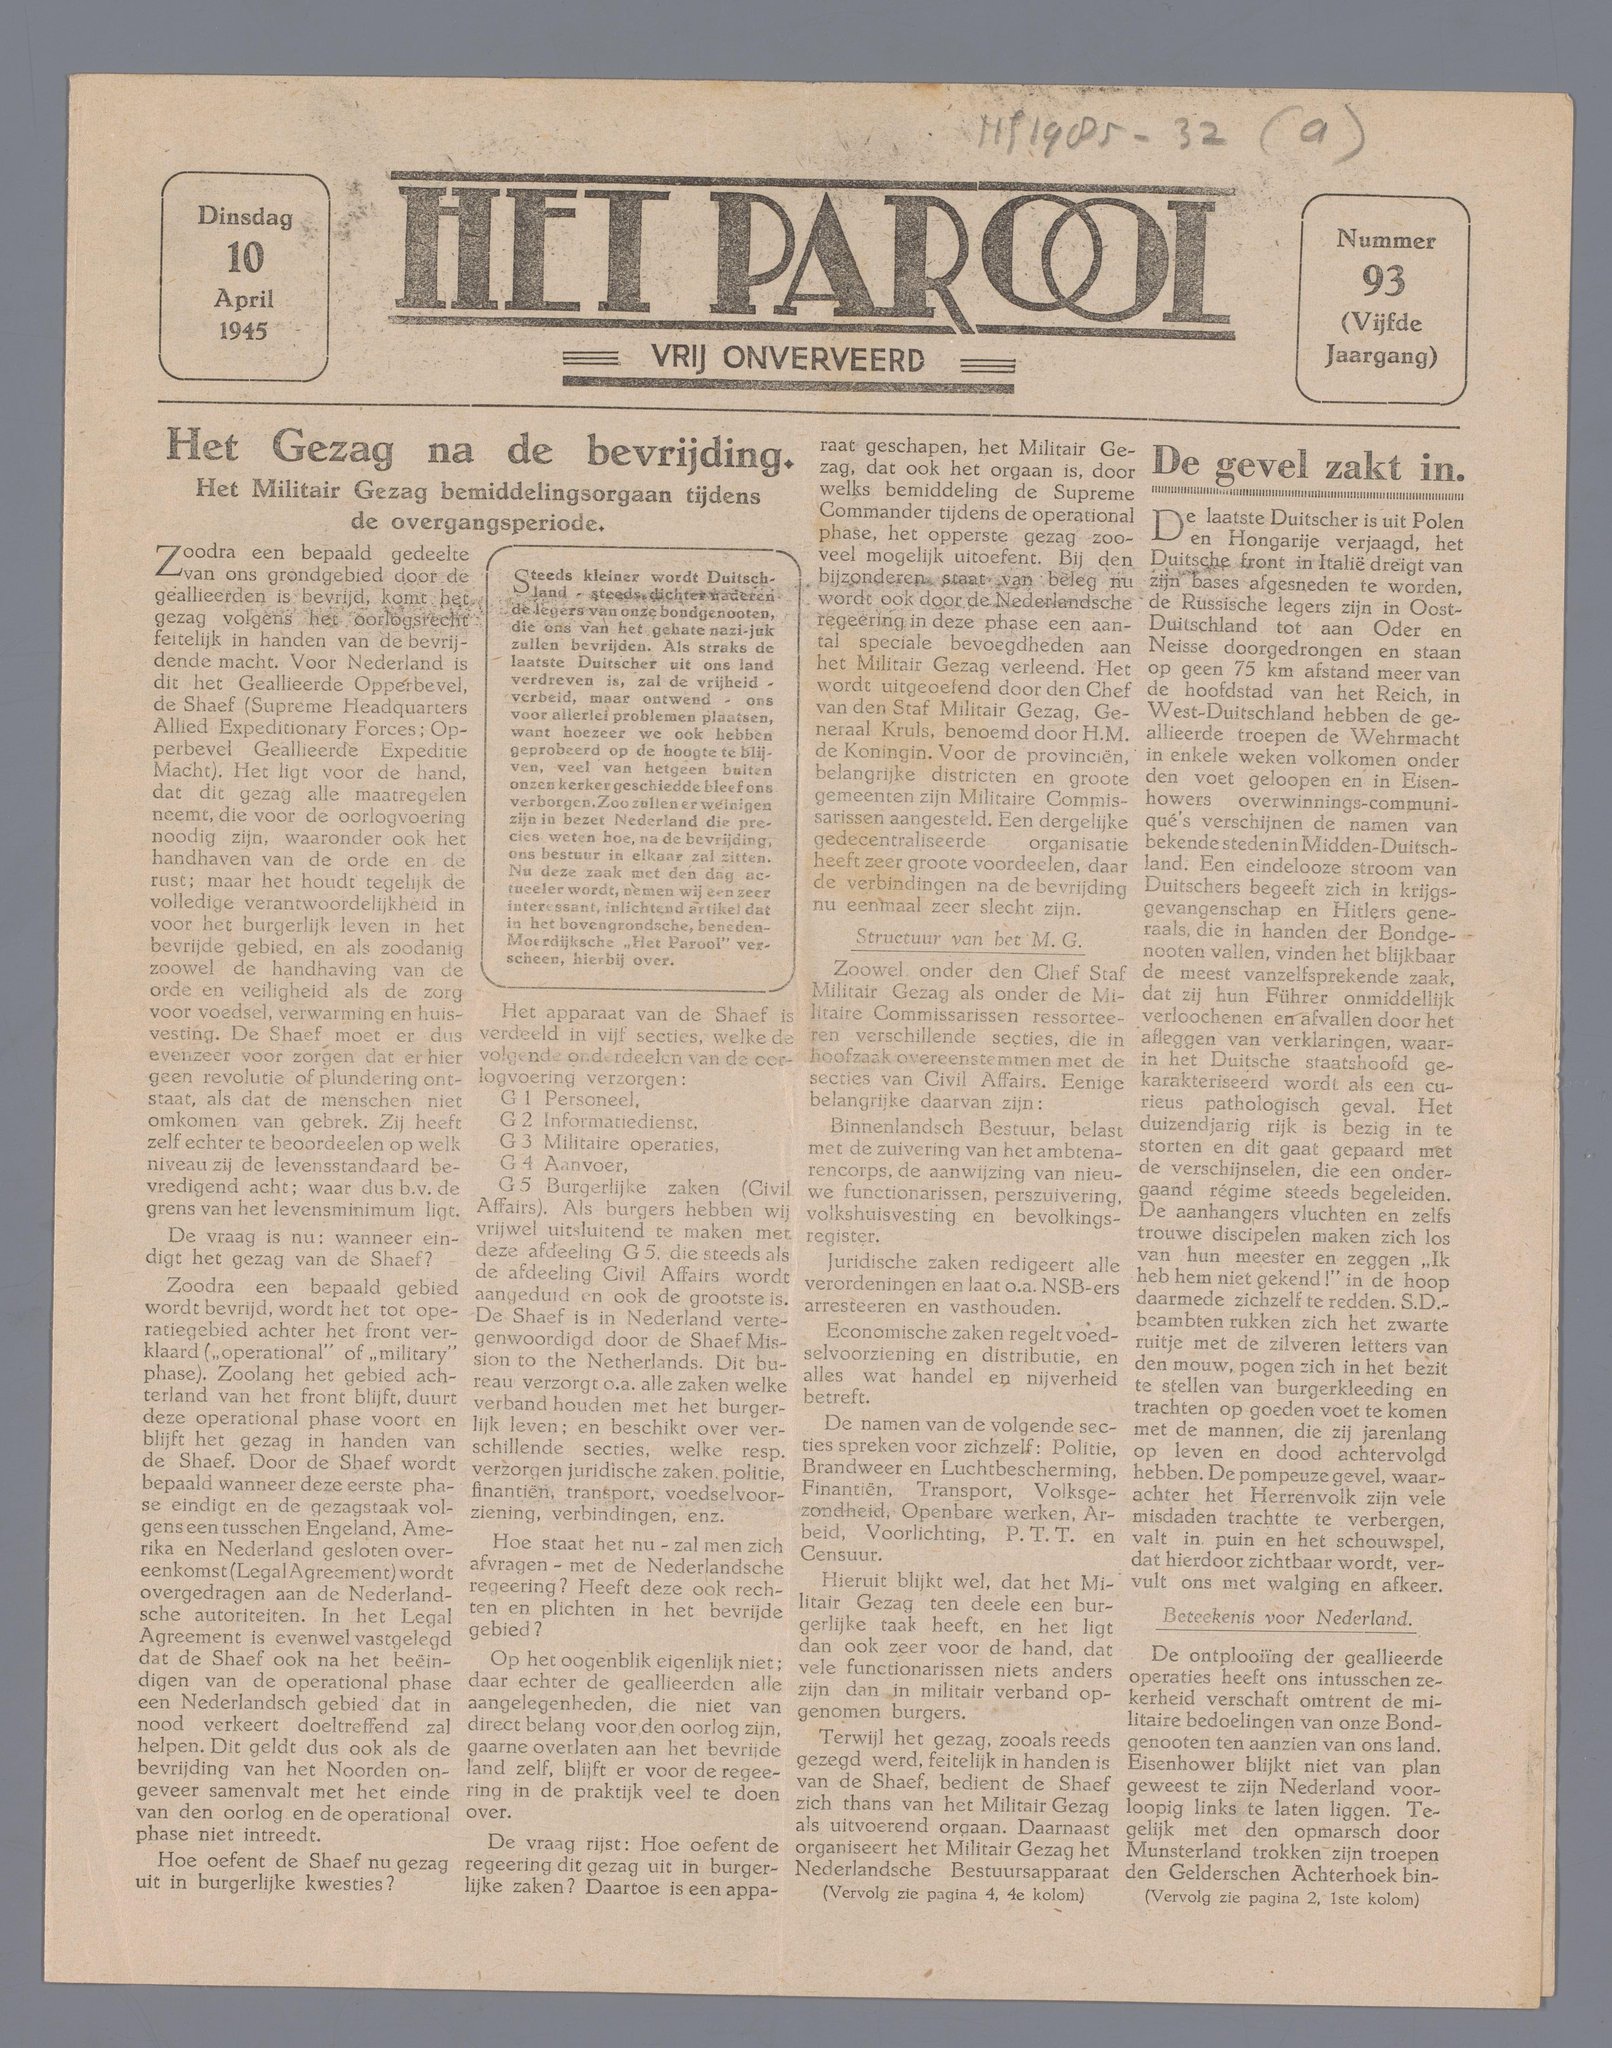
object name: newspaper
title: Illegale 'Het Parool', 10 april 1945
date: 1945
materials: ink, paper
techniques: printing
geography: amsterdam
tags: netherlands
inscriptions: date: ‘10 april 1945’, title: ‘Het Parool’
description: Illegaal exemplaar van Het Parool van 10 april 1945.